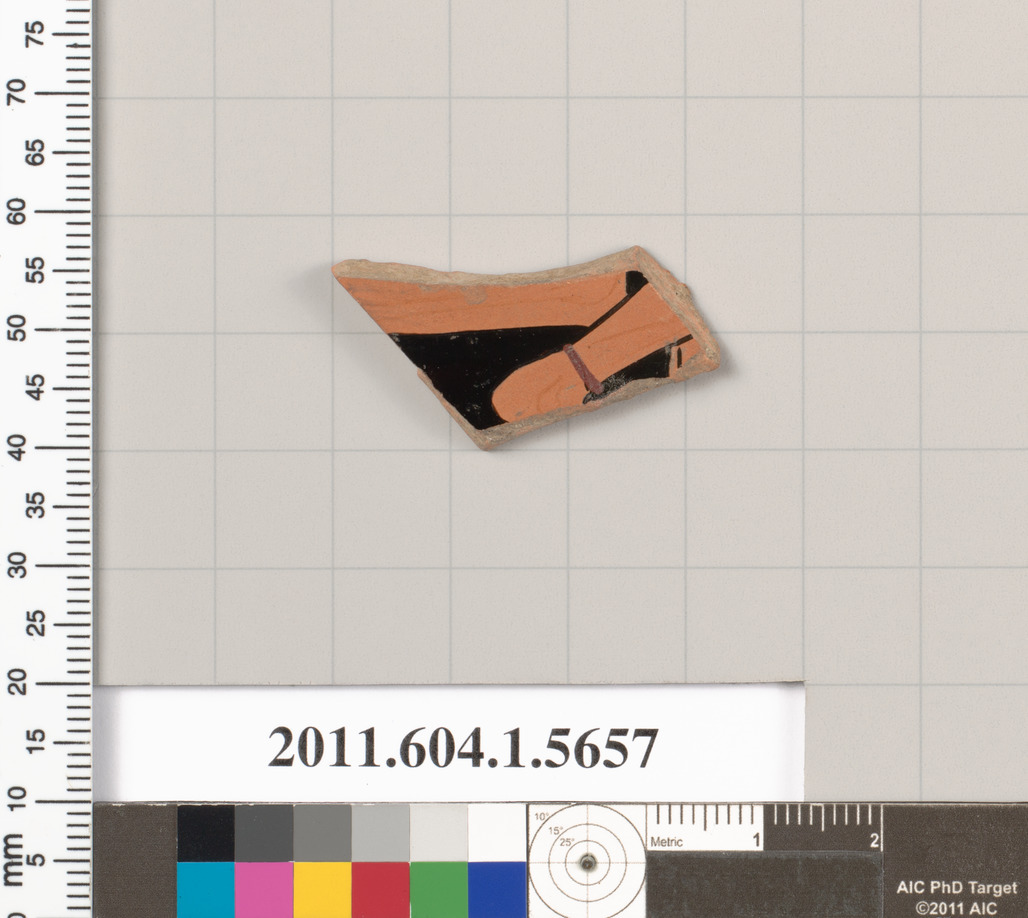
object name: kylix fragment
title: Terracotta fragment of a kylix (drinking cup)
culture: greek, attic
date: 500-480 BCE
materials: terracotta